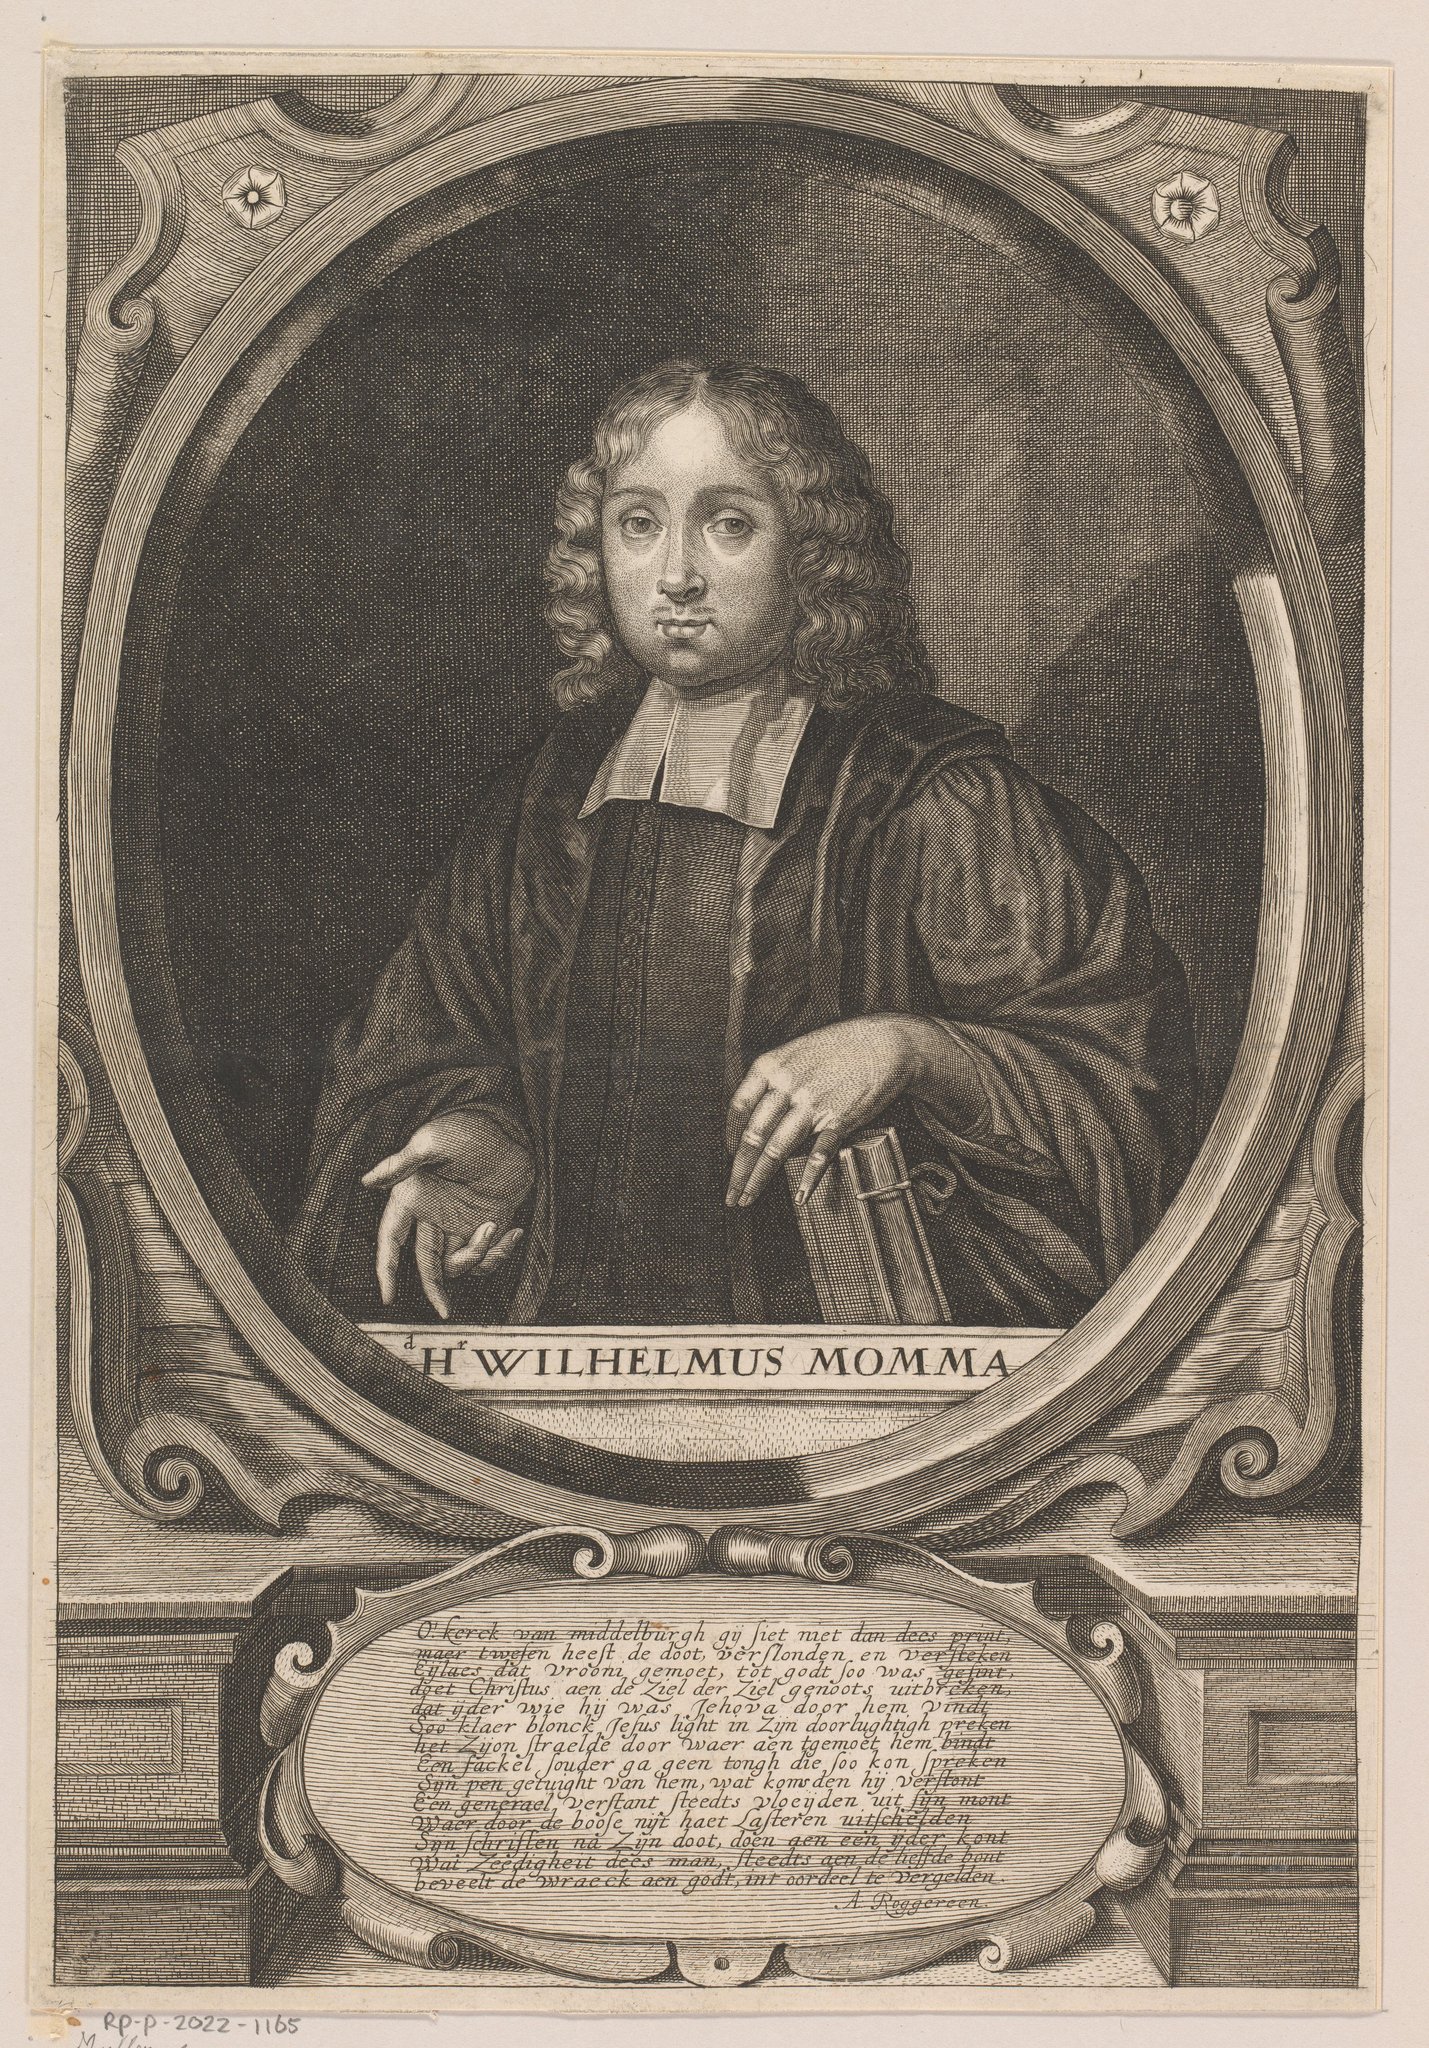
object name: print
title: Portret van Wilhelmus Momma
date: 1676-1679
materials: paper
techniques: engraving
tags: delft, historical persons, the bible as a book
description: Met veertienregelig Nederlands vers als onderschrift.